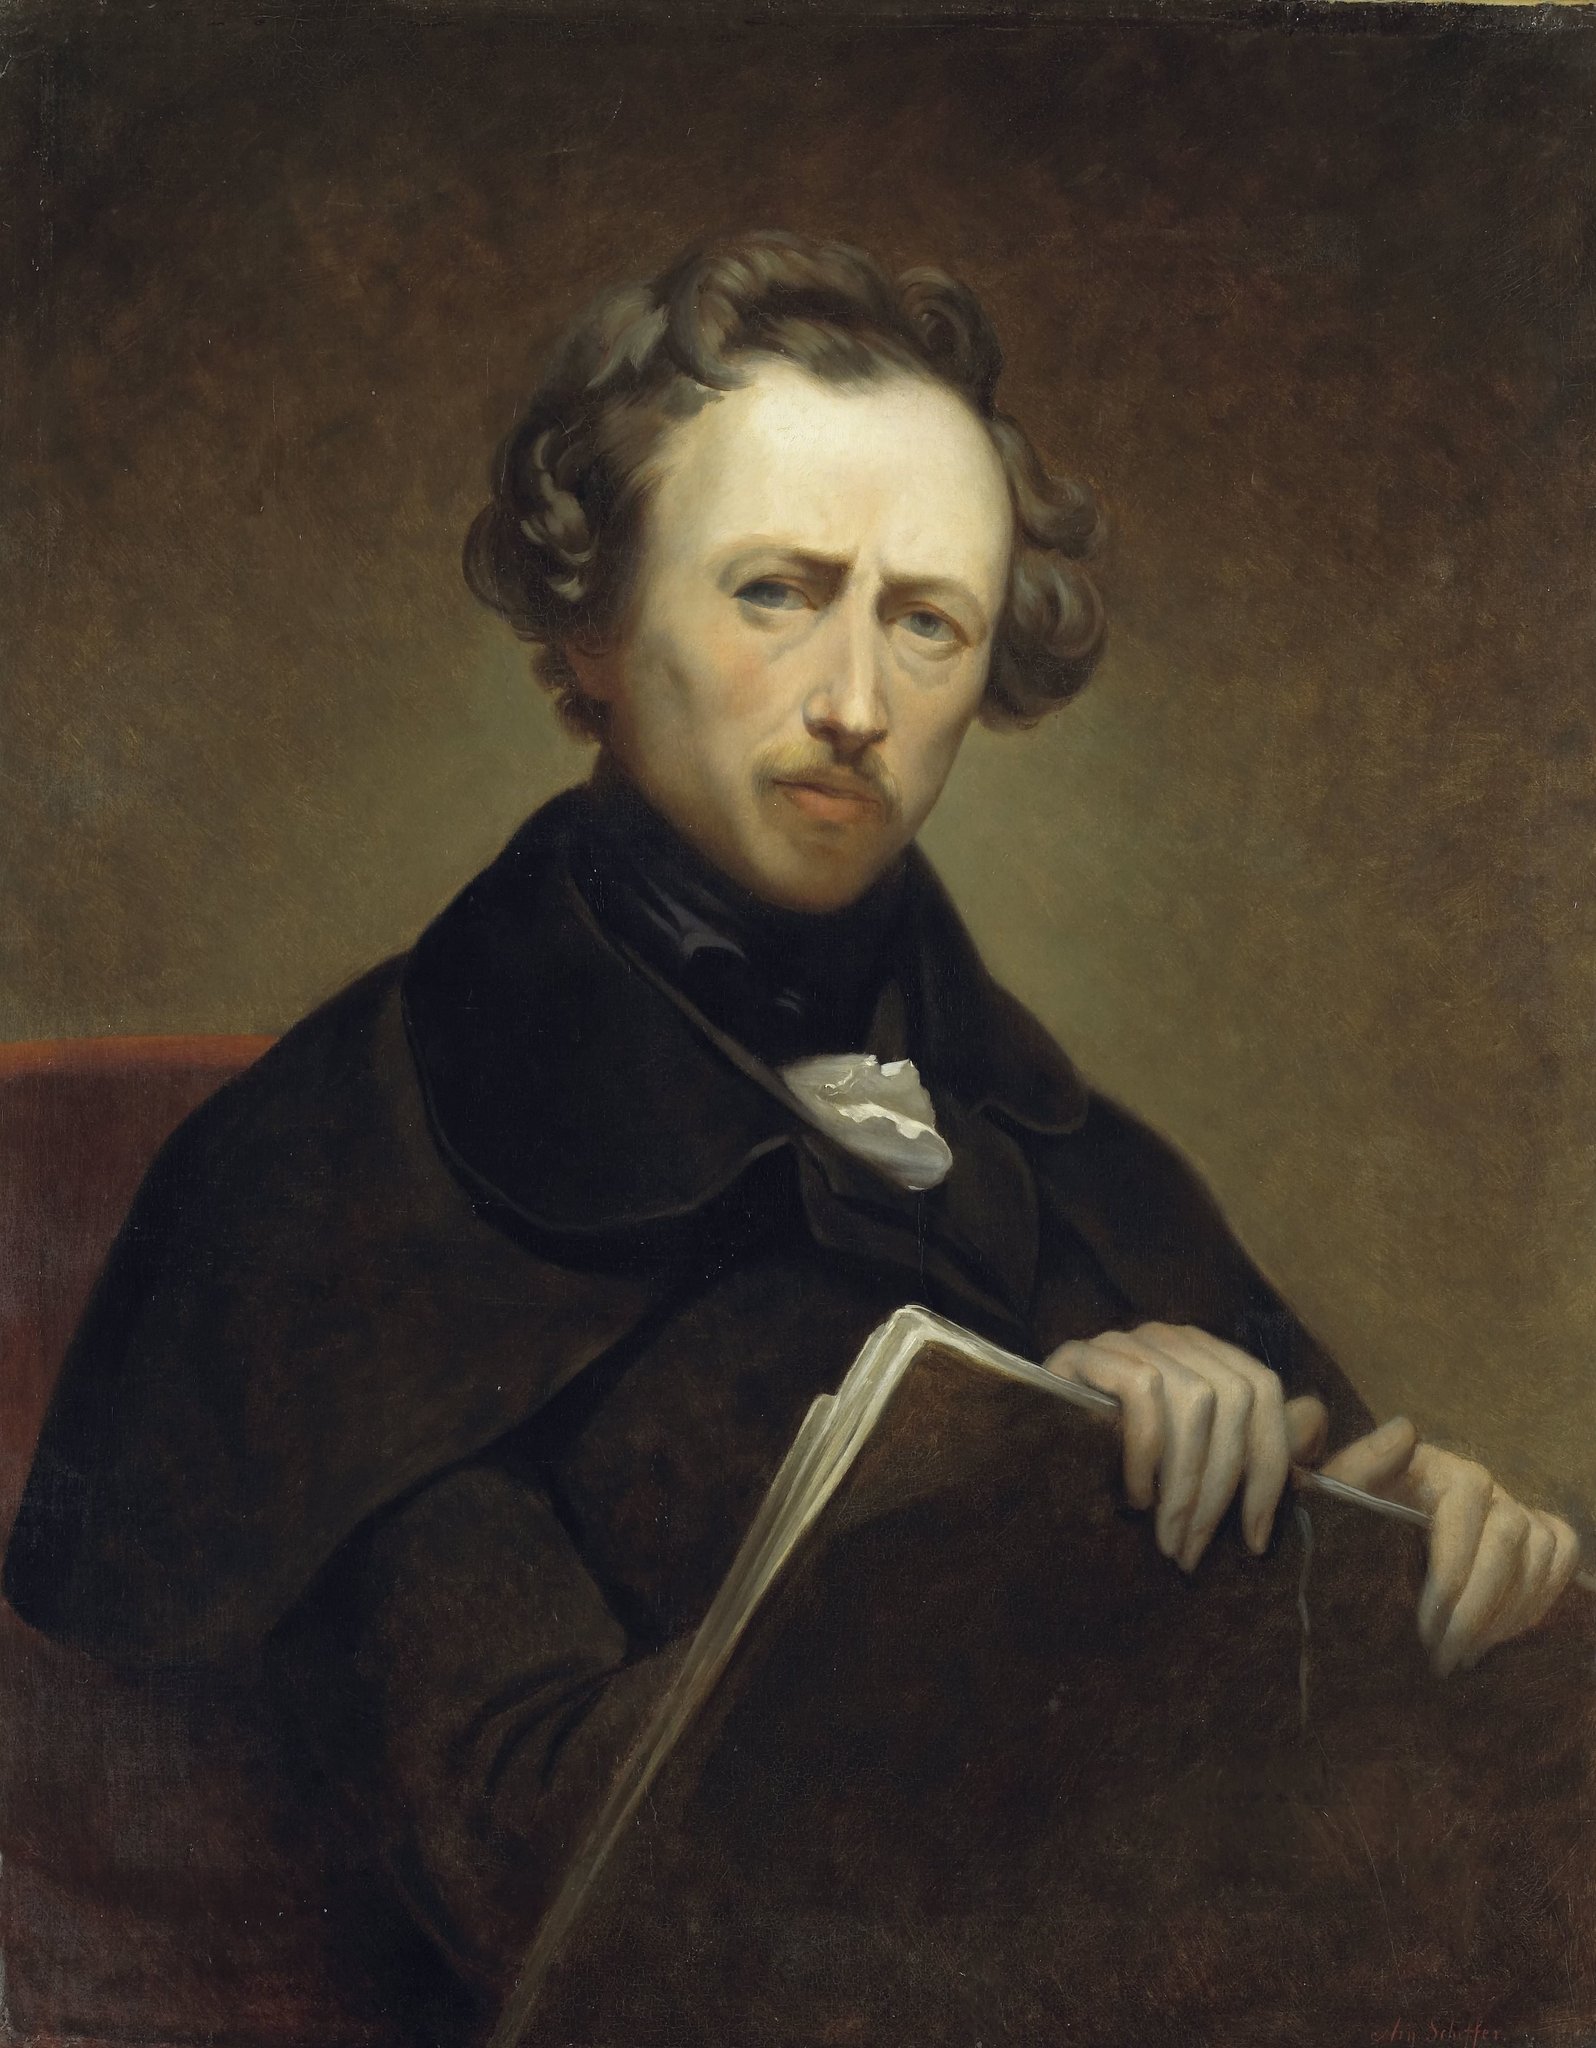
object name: painting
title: Self Portrait at the age of 43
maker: ary scheffer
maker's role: draughtsman, painter, print maker, sculptor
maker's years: 1795-1858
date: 1838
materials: canvas, oil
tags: dordrecht, painter, print maker, draughtsman, sculptor, ary scheffer, portrait, self-portrait of artist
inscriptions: signature: ‘Arij Scheffer’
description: Zelfportret van de schilder Ary Scheffer op 43-jarige leeftijd. Zittend, ten halven lijve, met een portefeuille in de handen.